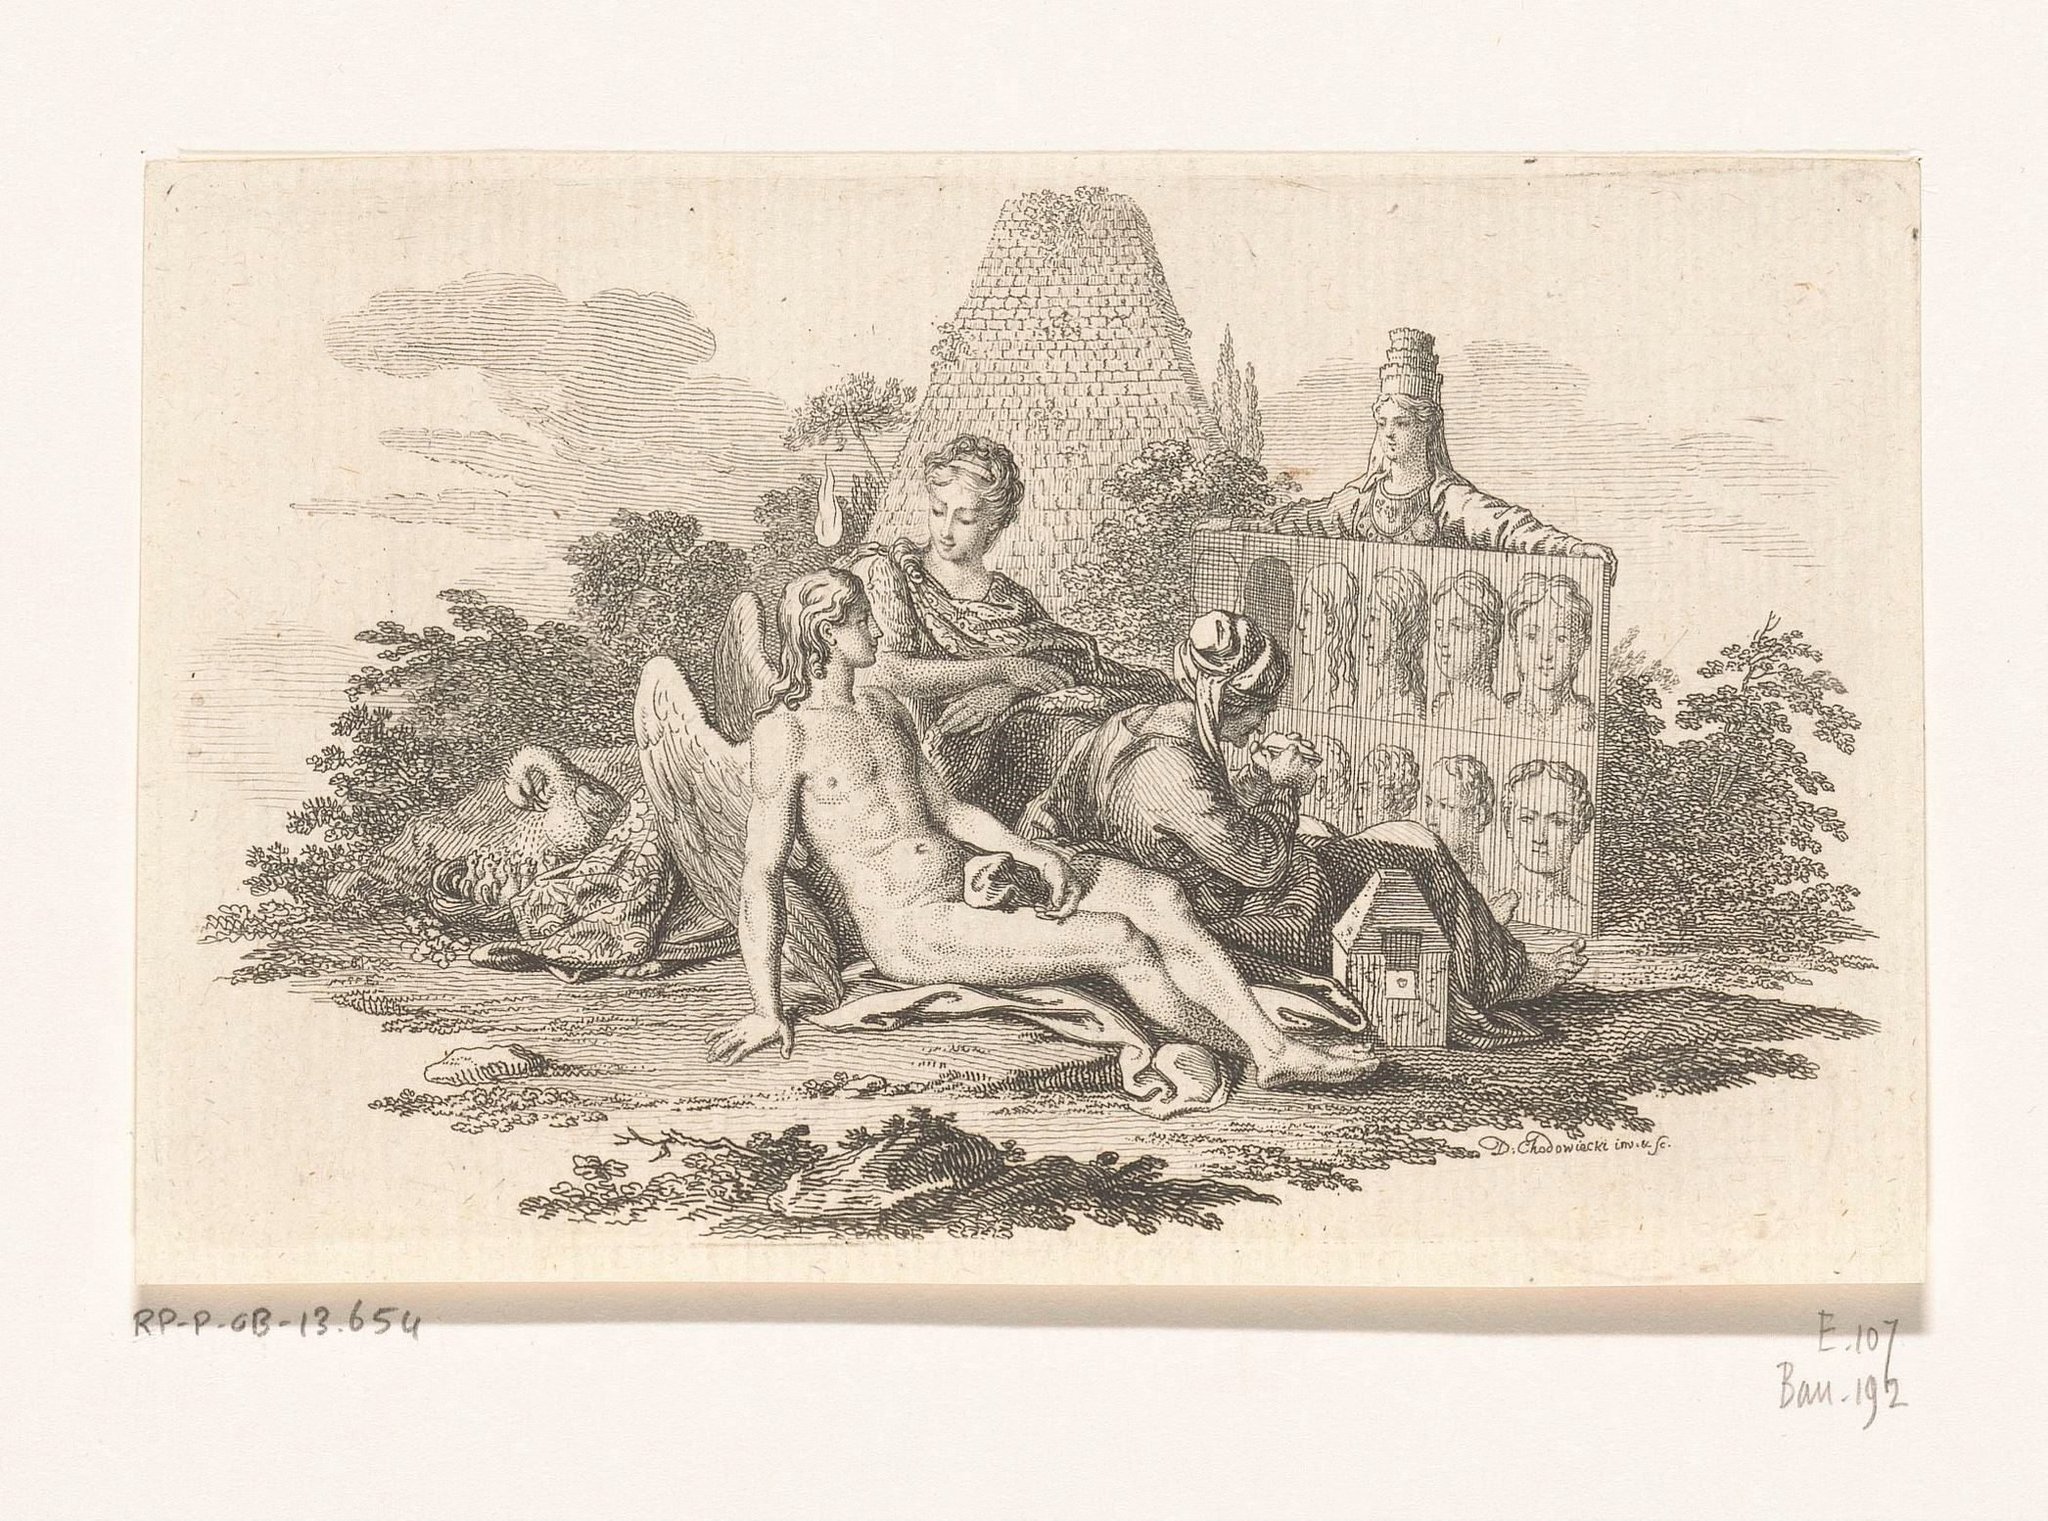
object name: print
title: Genius van de fysionomie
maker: daniel nikolaus chodowiecki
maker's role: draughtsman, print maker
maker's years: 1726-1801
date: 1774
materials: paper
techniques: etching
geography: berlin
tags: johann caspar lavater, 'natura' (allegorical figure or scene; or as diana of ephesus, with many breasts); 'natura' (ripa), pyramid (historical grave form), water-birds: pelican, 'genio' (ripa)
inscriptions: collector's mark: Lugt 240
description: Allegorische voorstelling met in het midden de 'Genius van de fysionomie', een jongeman met vleugels met een vlam boven zijn hoofd. Hij kijkt naar Natura die een bord met gezichten omhoog houdt. Naast hem zit een figuur met een kist, mogelijk staat deze voor 'de schat aan ervaringen'. De vrouw achter hem symboliseert waarschijnlijk 'de goedheid van het hart'. In de achtergrond een afgestompte piramide en een pelikaan met een nest met jongen.